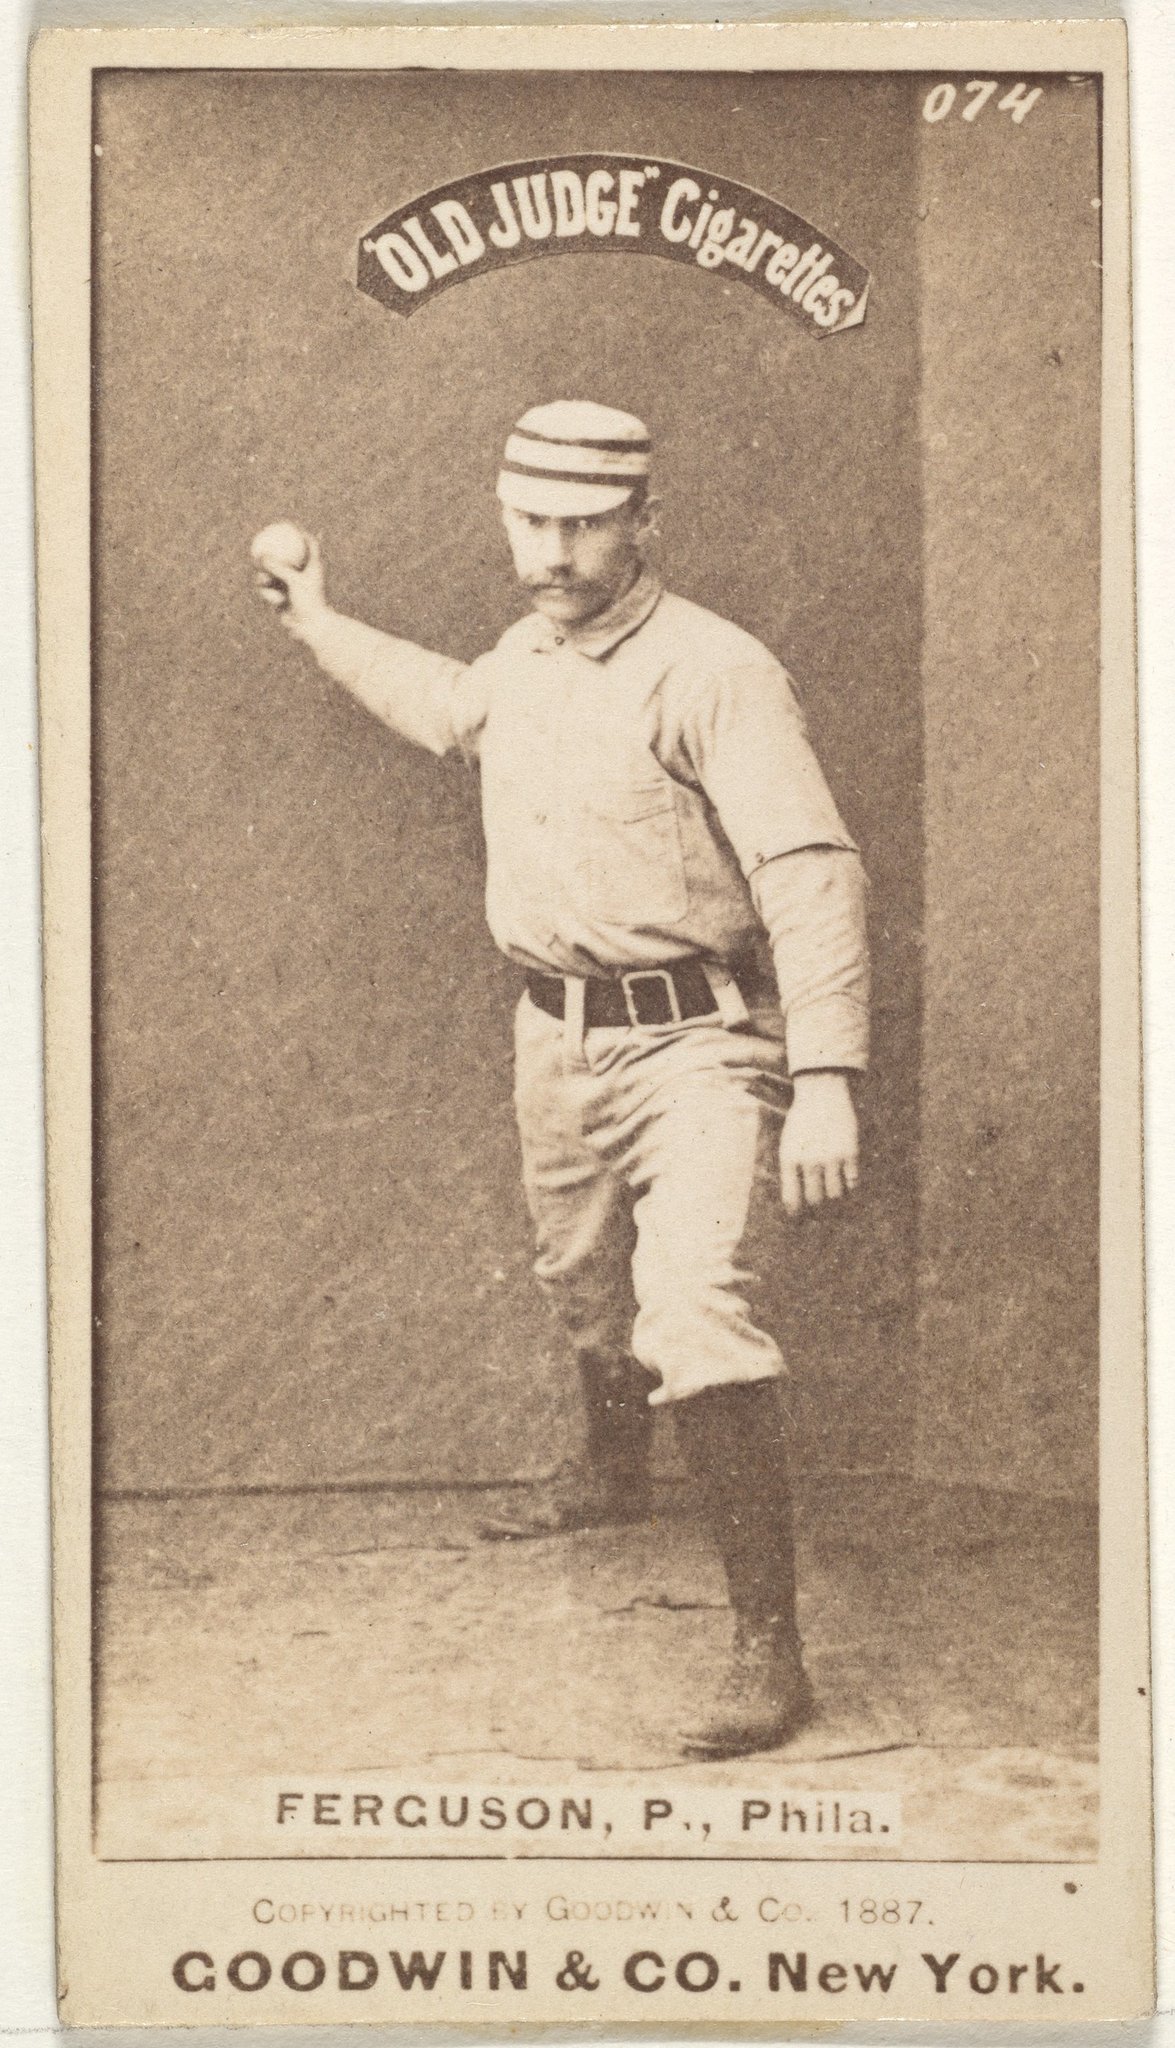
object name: baseball card, photograph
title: Charles J. "Charlie" Ferguson, Pitcher, Philadelphia, from the Old Judge series (N172) for Old Judge Cigarettes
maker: goodwin & company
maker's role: publisher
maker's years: 1850-1950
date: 1887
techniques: albumen silver print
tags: men,portraits,baseball,athletes